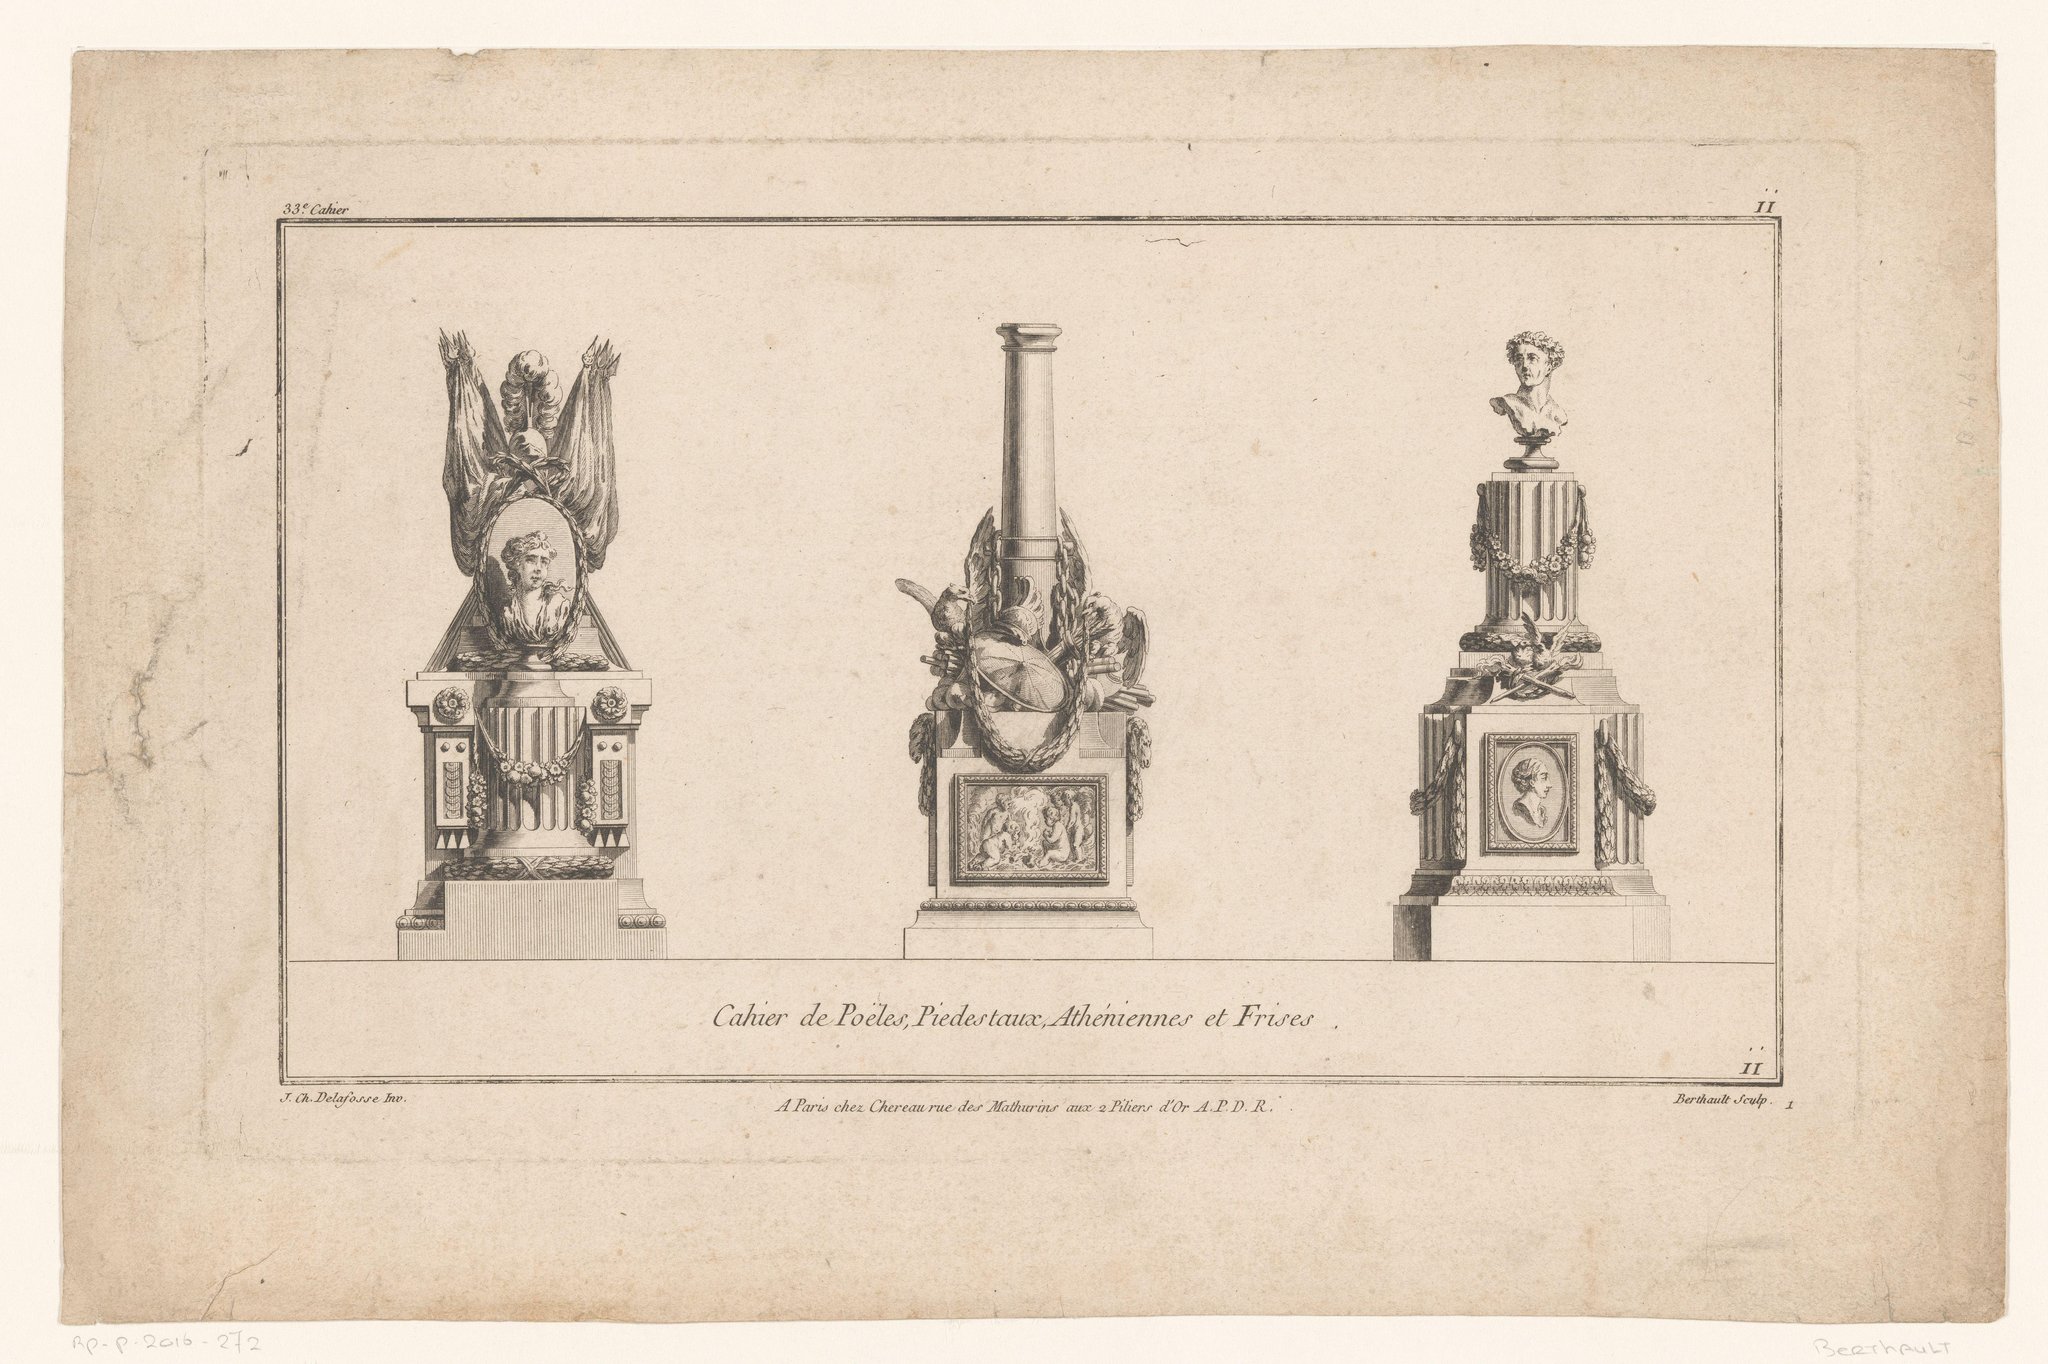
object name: titelprent, frontispice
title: IIe Volume De l'Oeuvre de J. Ch. Delafosse (...)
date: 1771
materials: paper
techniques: engraving, etching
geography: paris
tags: monument, statue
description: Links een monument met een medaillon met portret, vlaggen en een helm. In het midden een monument met een zuil, wapens en twee adelaars. Rechts een monument met een mannenbuste op een zuil.